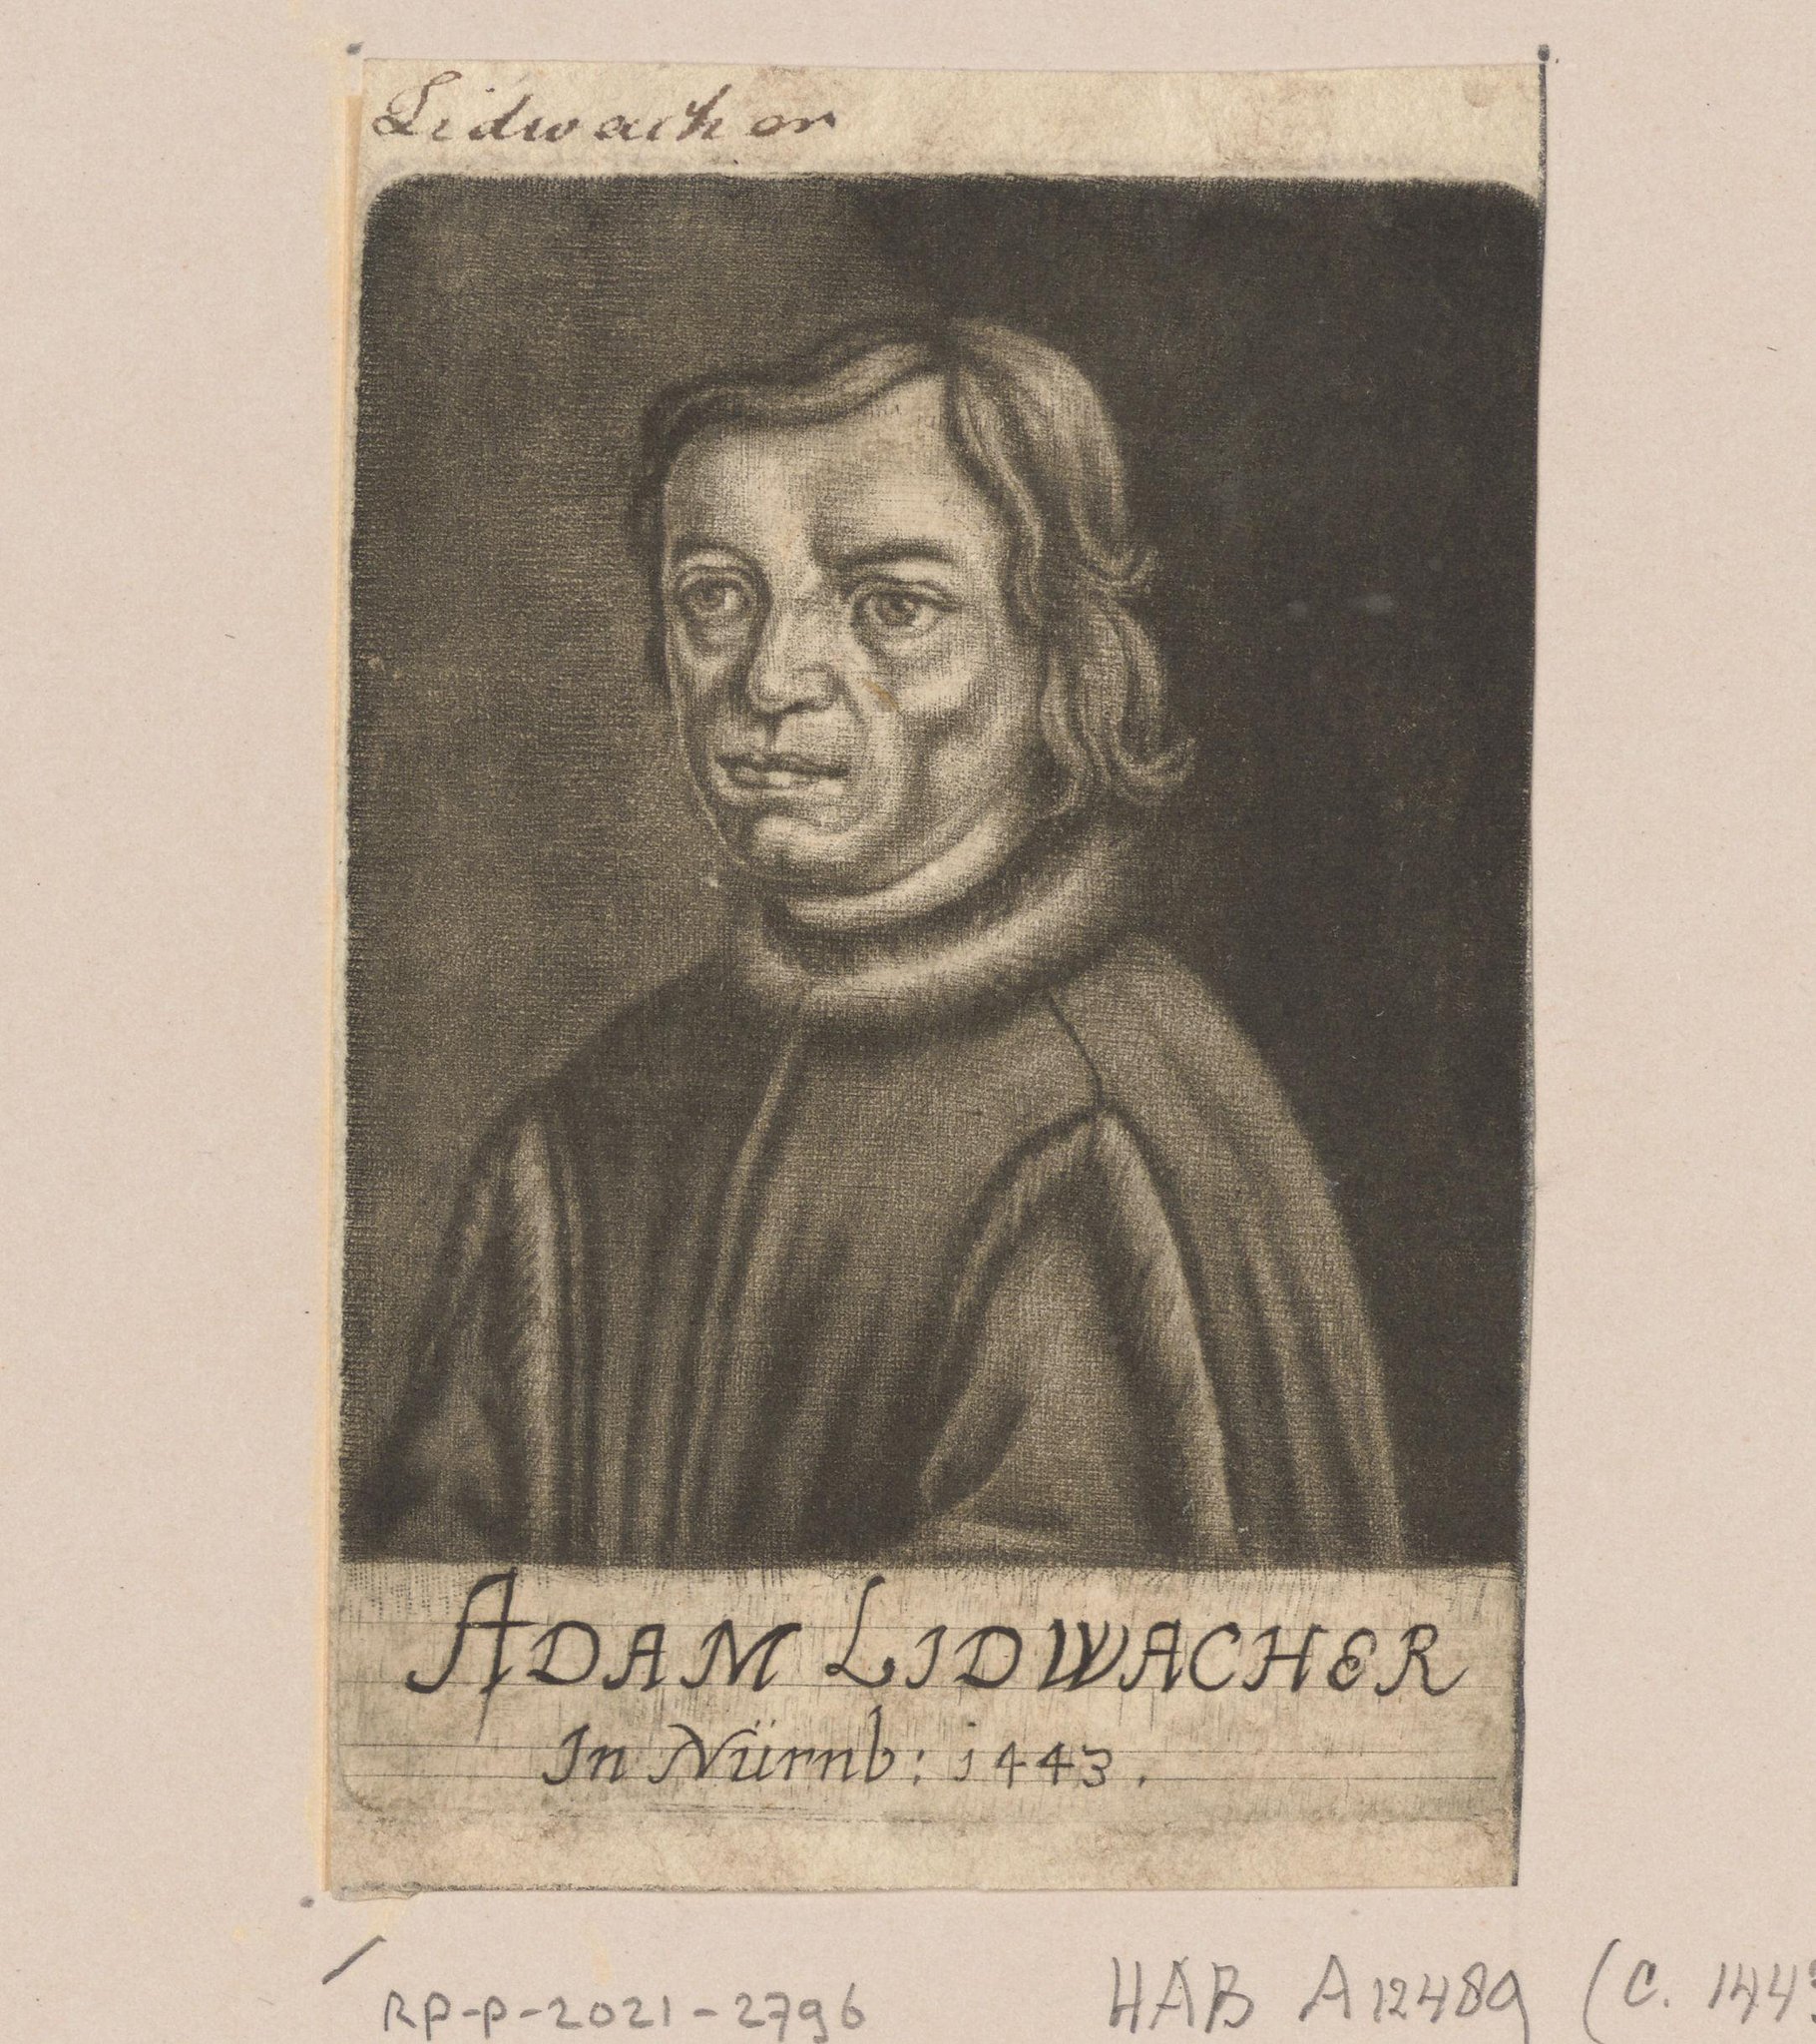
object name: print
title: Portret van Adam Lidwacher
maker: georg fennitzer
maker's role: print maker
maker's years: 1646-1722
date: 1656-1722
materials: paper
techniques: mezzotint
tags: historical persons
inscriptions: inscription: ‘Lidwacher’